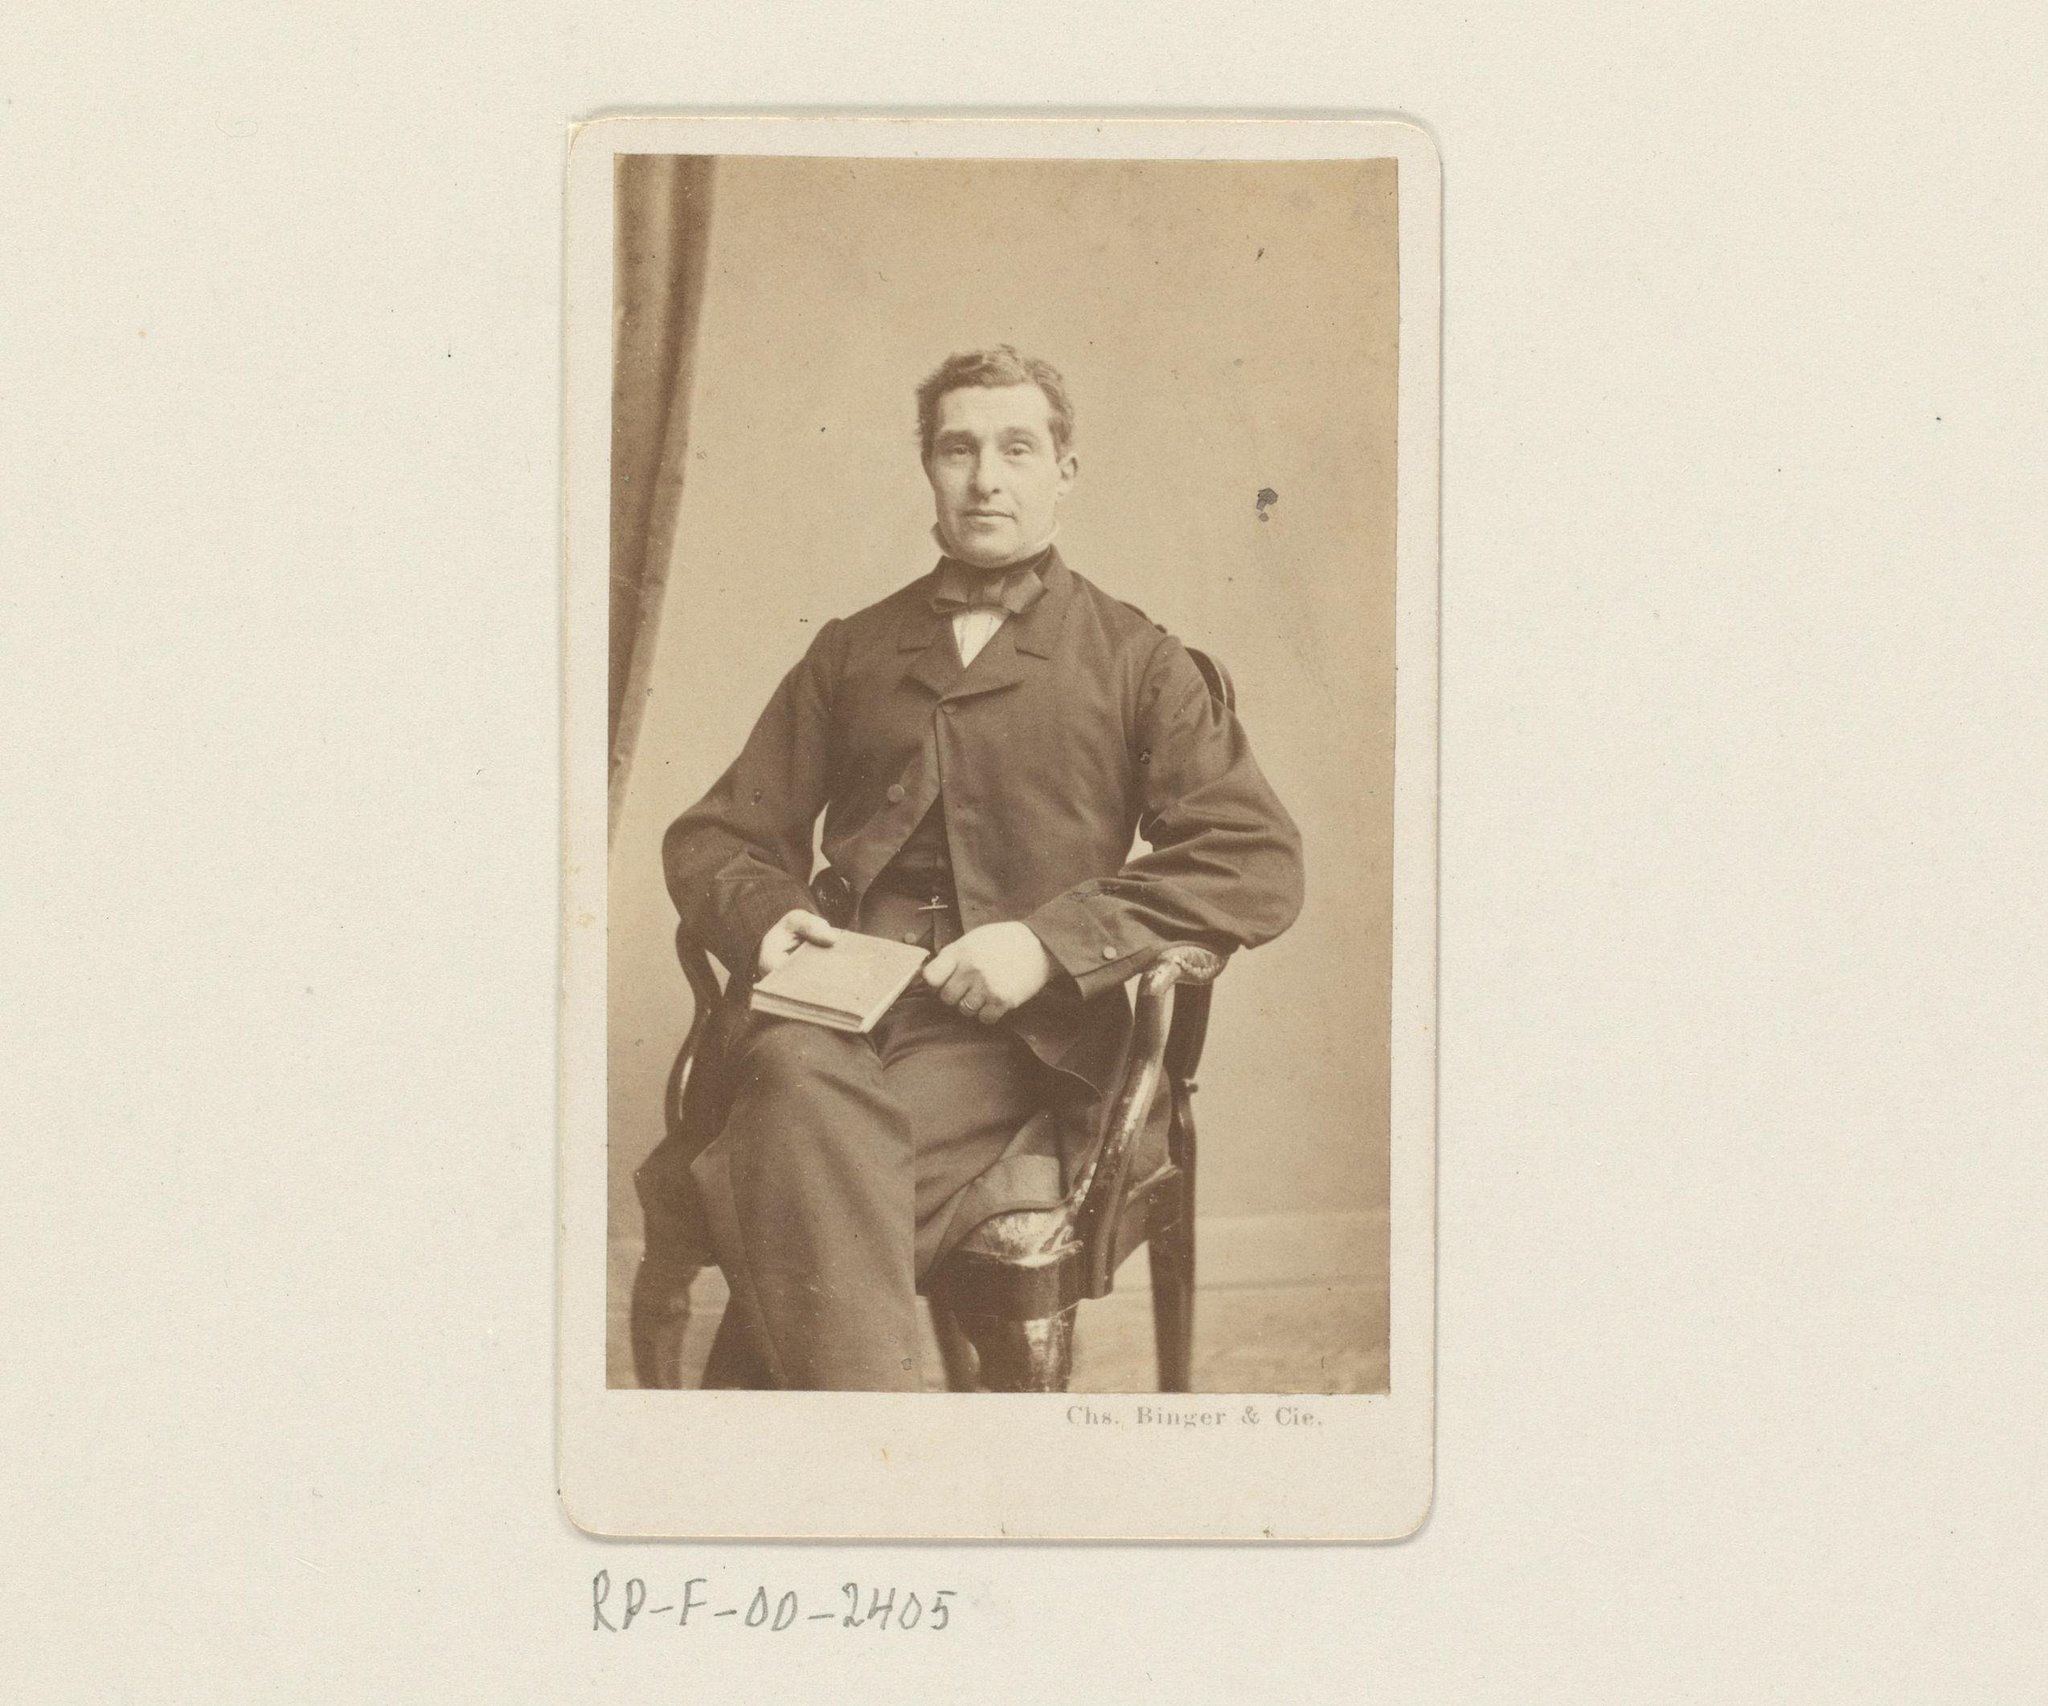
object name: carte de visite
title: Portret van C.J. Brutel de la Rivière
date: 1862-1882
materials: cardboard, paper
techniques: albumen print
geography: haarlem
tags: historical persons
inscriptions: inscription: ‘Chs. Binger & Cie./ Zijlstraat/ Haarlem’, inscription: ‘Brutel de la Rivière’